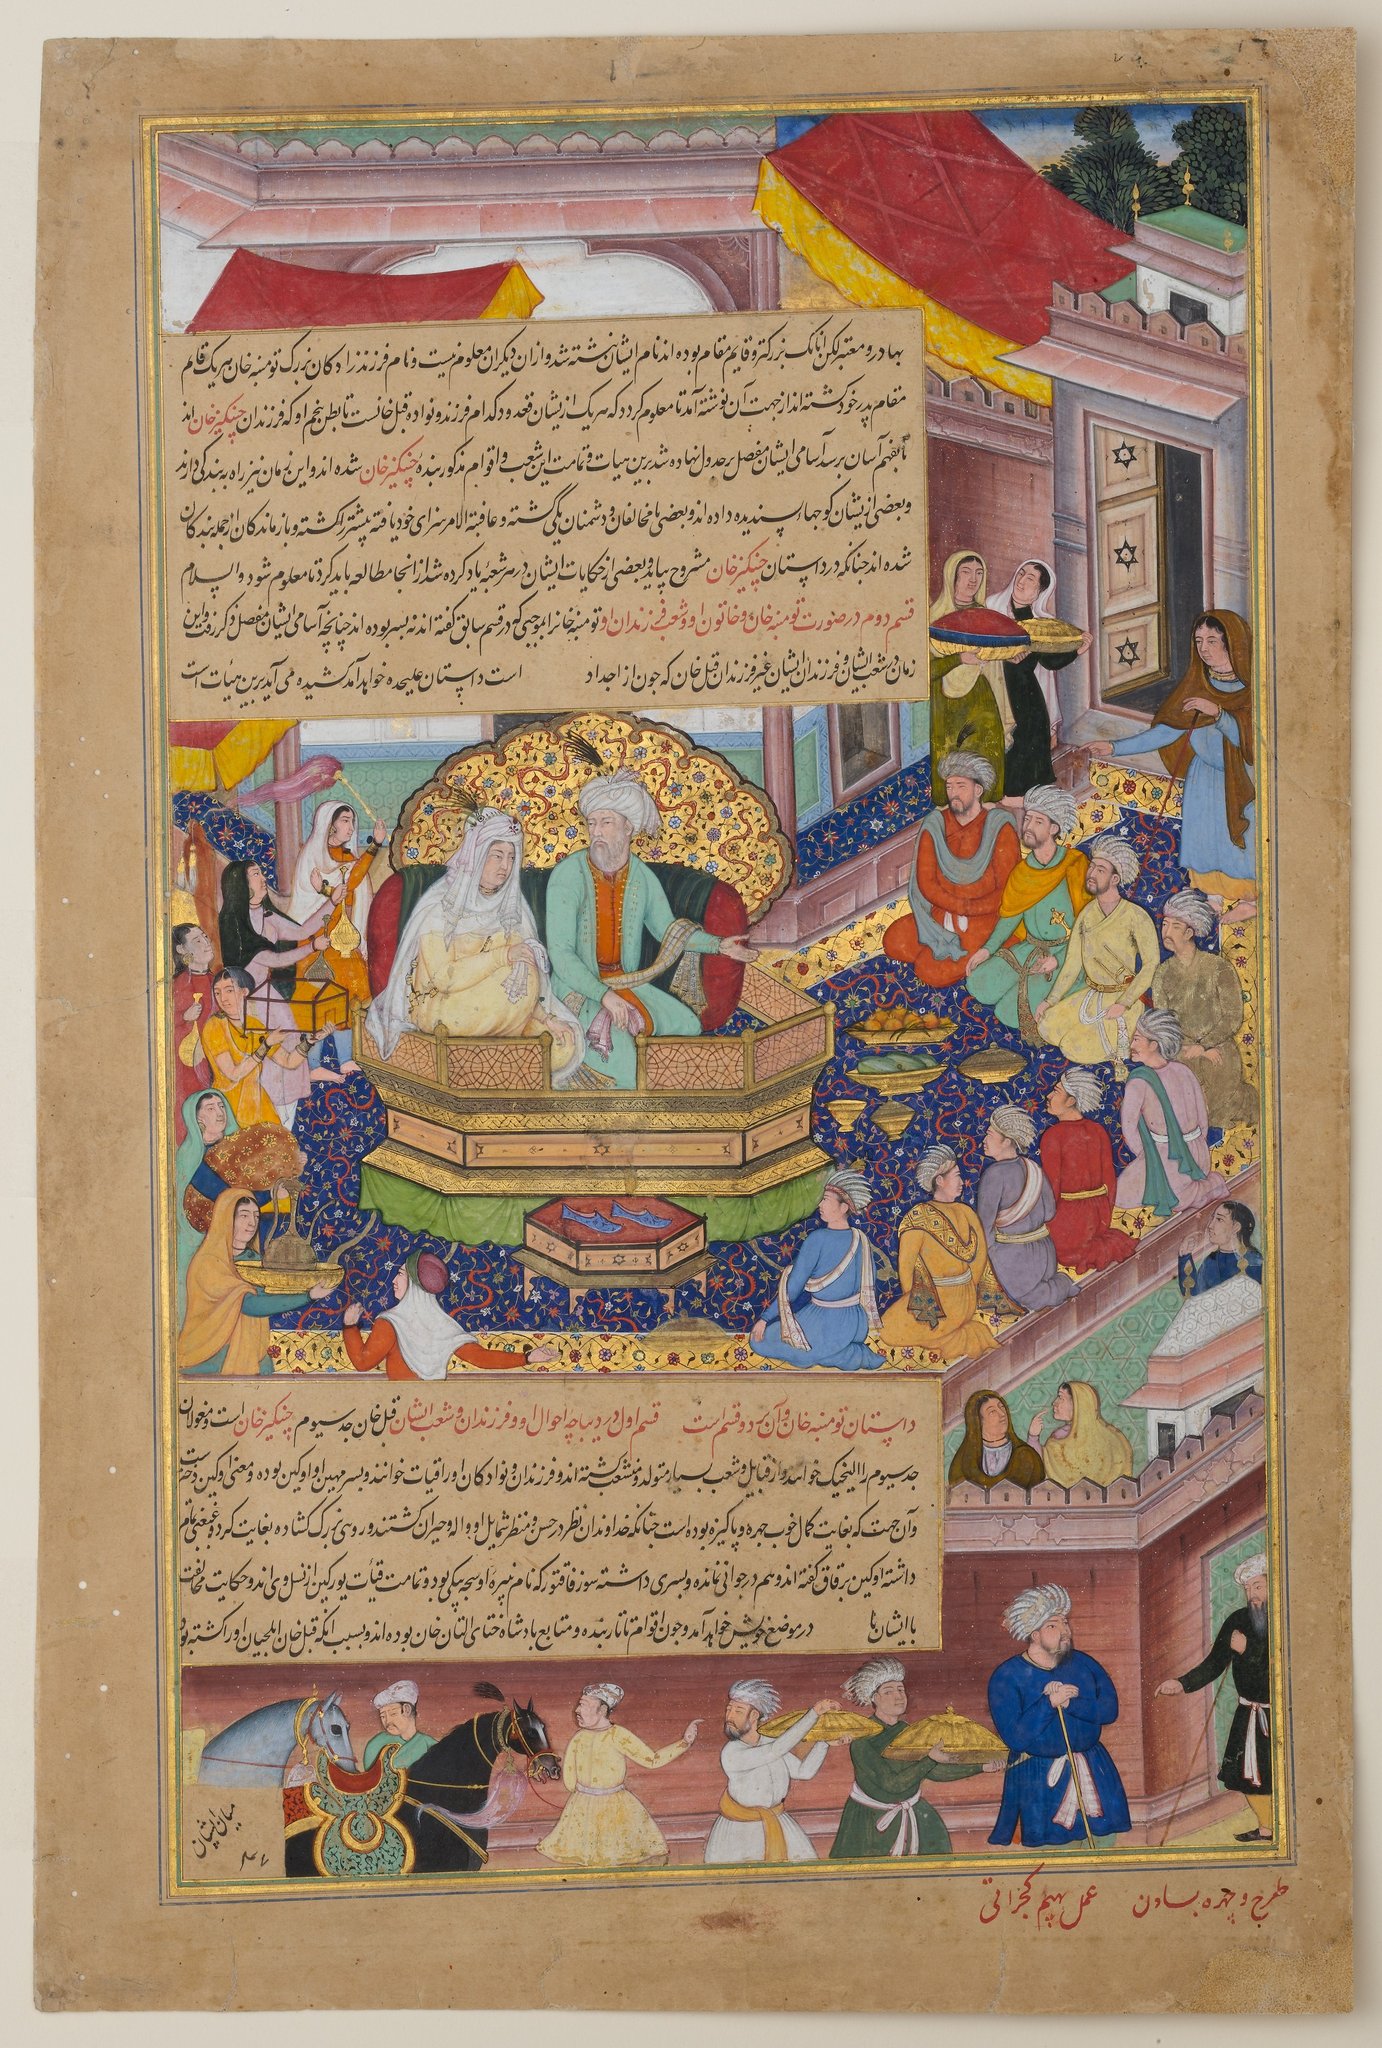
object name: folio from an illustrated manuscript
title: "Tumanba Khan, His Wife, and His Nine Sons", Folio from a Chingiznama (Book of Genghis Khan)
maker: basawan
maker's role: artist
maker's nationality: indian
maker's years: 1556-1600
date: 1596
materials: gold, ink, paper, watercolor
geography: pakistan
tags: men,women,horses